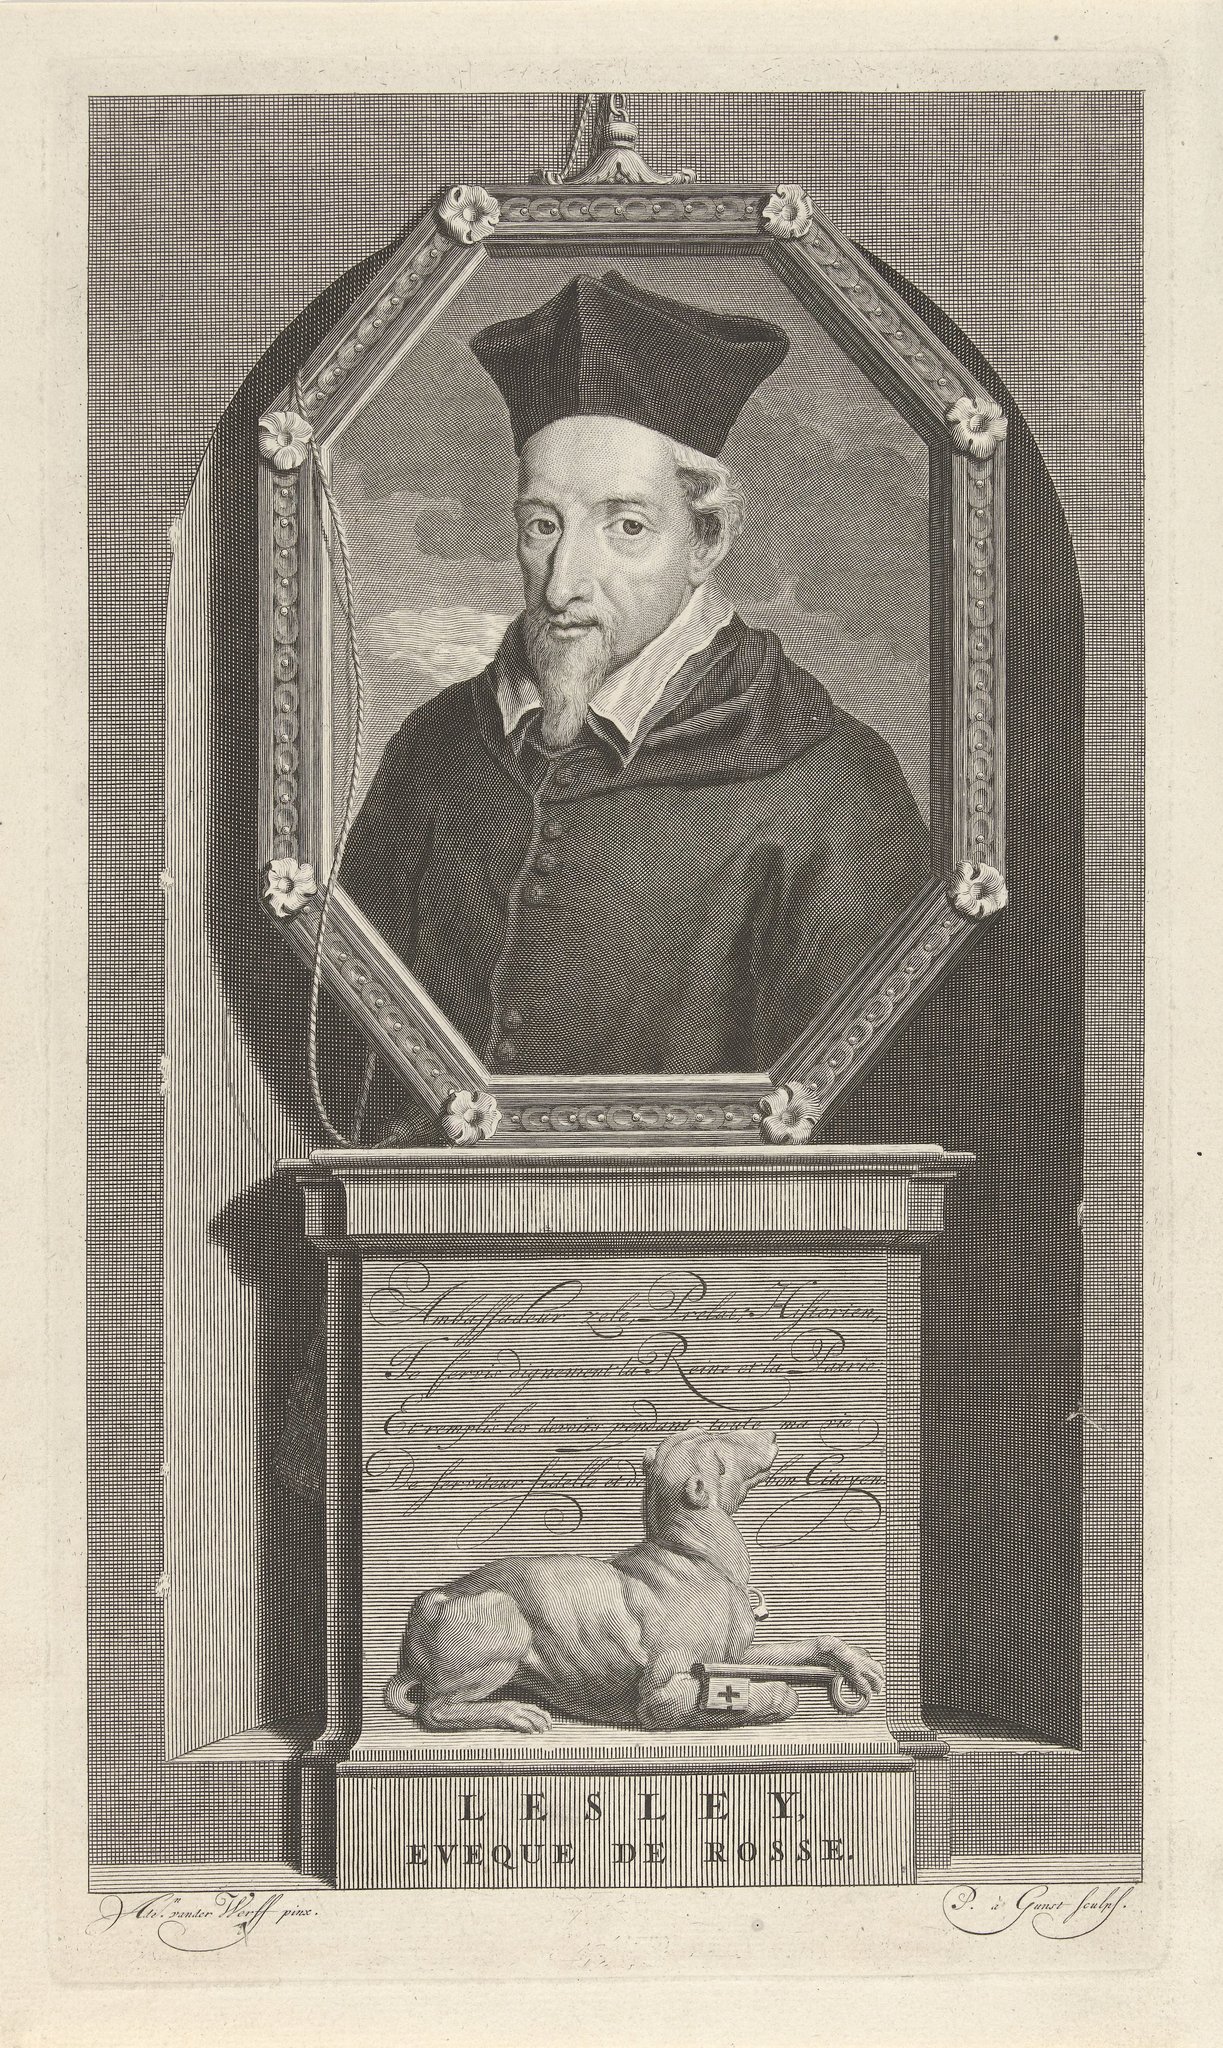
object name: print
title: Portret van bisschop John Lesley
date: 1669-1731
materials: paper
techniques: engraving, etching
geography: amsterdam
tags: brussels, key, dog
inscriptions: collector's mark: Lugt 2228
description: John Lesley, bisschop van Ross en voorvechter van Maria Stuart. Onder het portret een hond met een sleutel. De prent heeft als onderschrift een Frans gedicht over zijn leven.